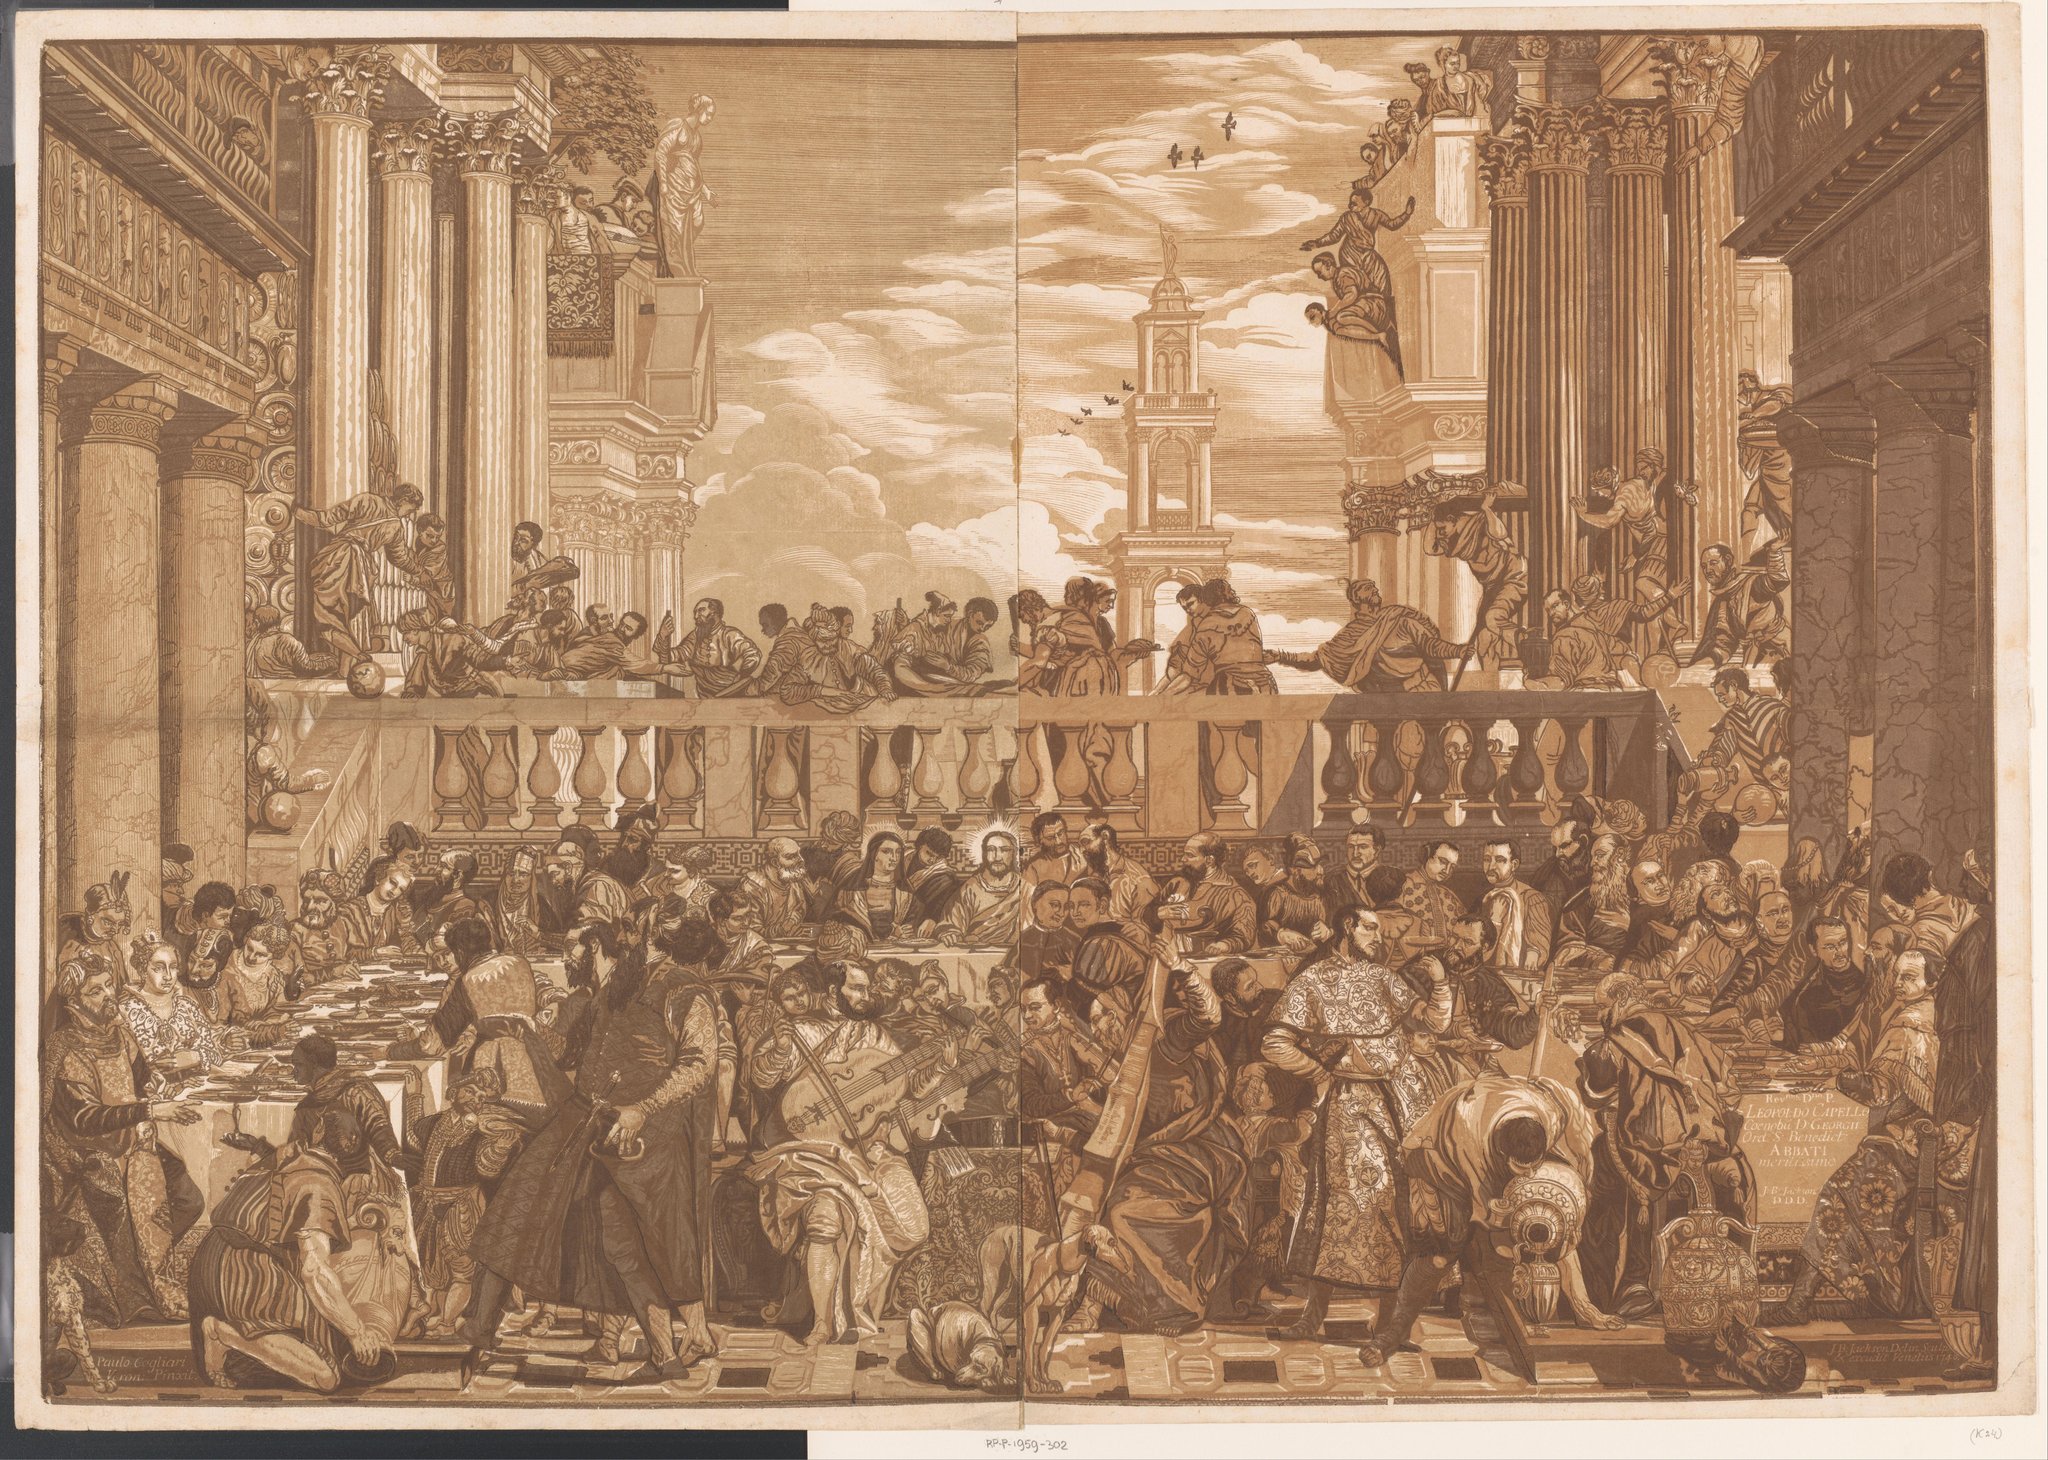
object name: print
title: Kunstwerken van Venetiaanse meesters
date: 1745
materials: paper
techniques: woodcut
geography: venice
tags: the marriage-feast at cana (john 2:1-11)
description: Prent maakt deel uit van een ongenummerde serie van 24 prenten.